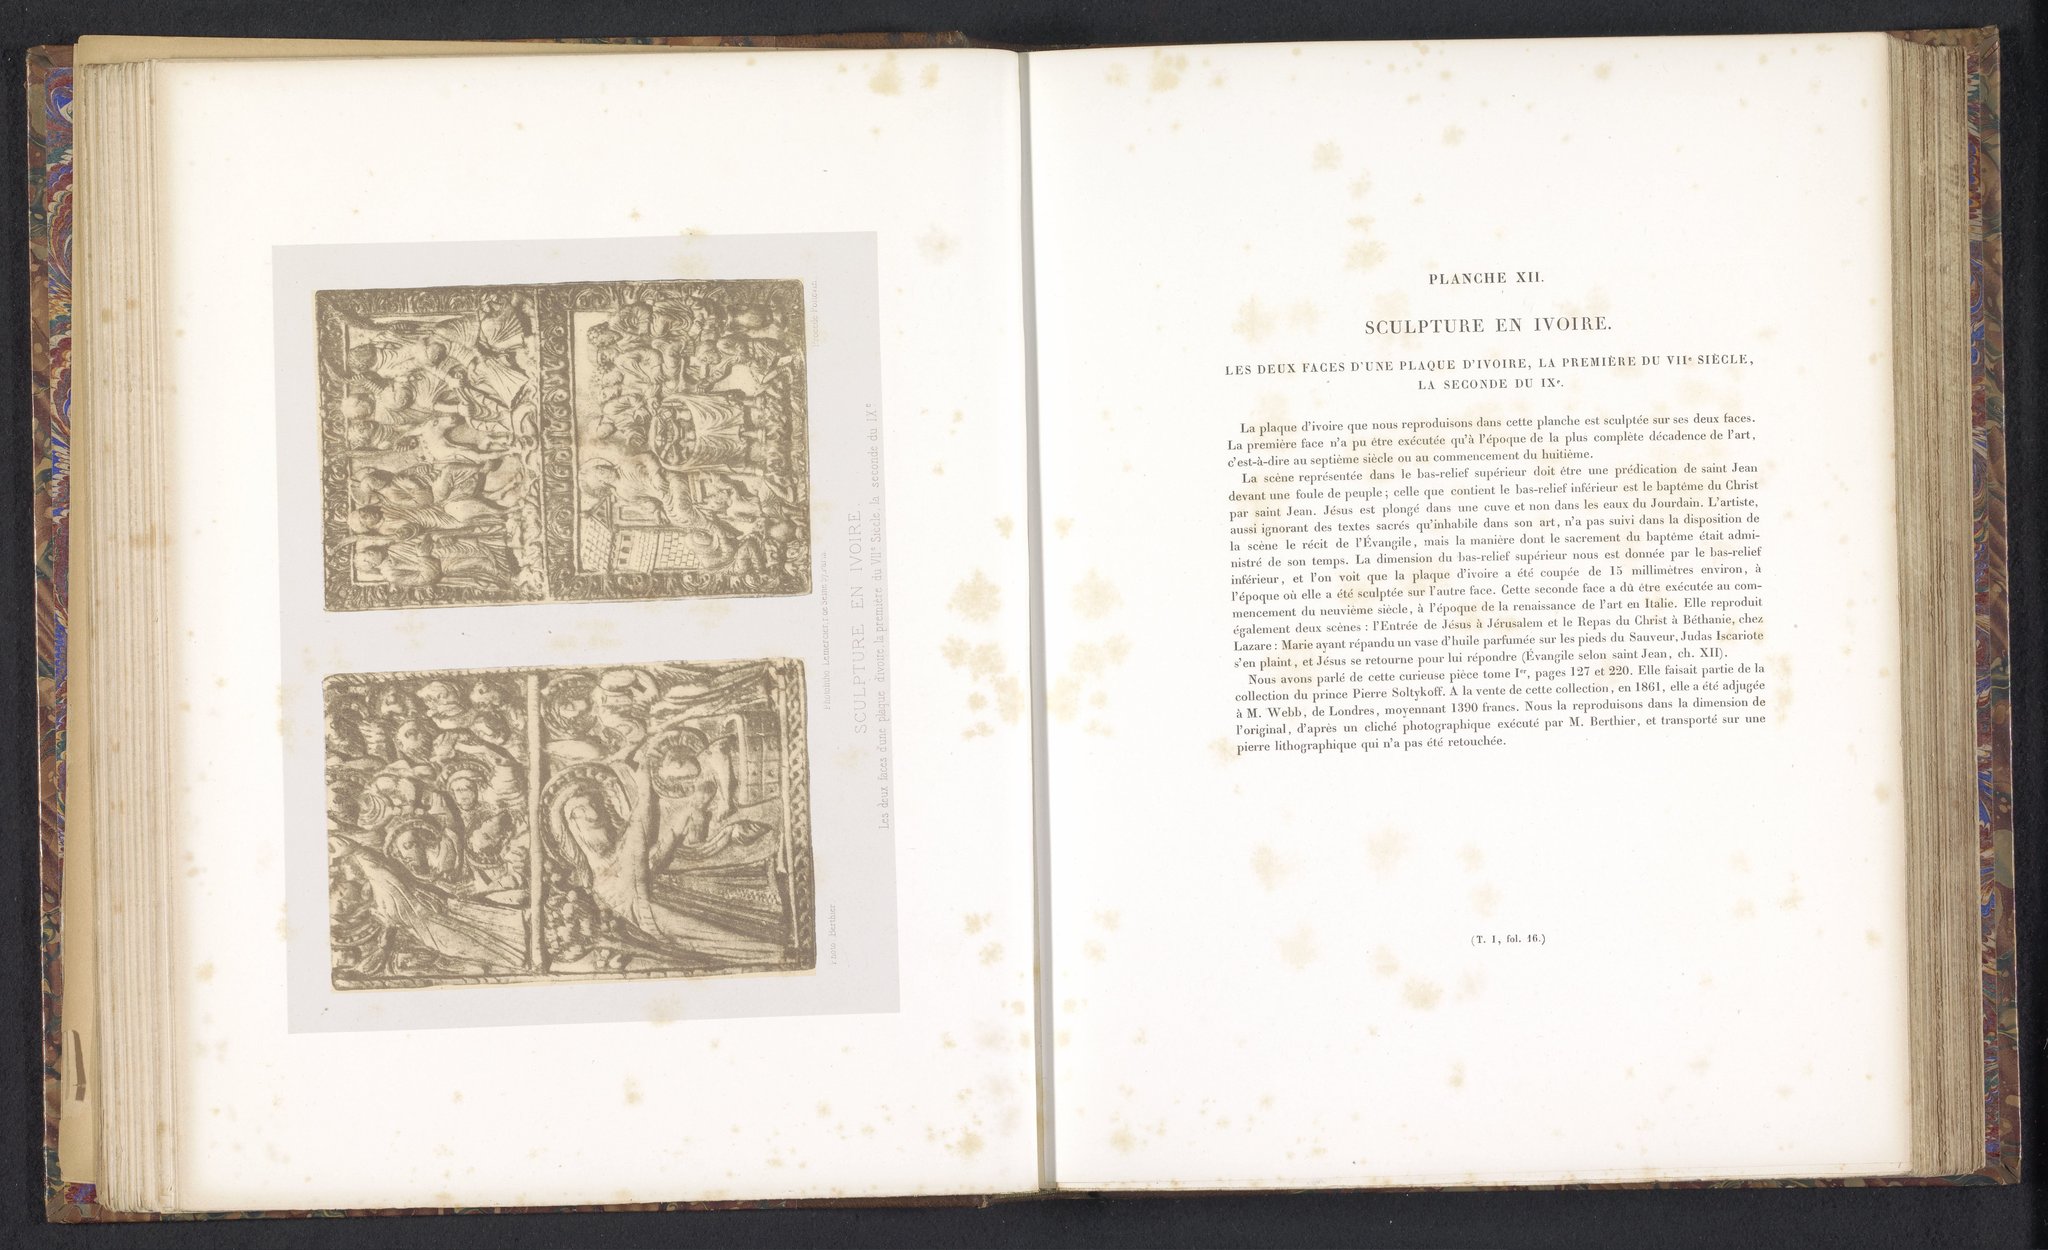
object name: photomechanical print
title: Twee zijden van een ivoren blad met reliëfs, voorstellende de doop van Christus en de intocht van Christus in Jeruzalem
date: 1859-1864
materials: paper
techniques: photolithography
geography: paris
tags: baptism of christ in the river jordan: john the baptist pouring out water on christ's head: the holy ghost descends, entry into jerusalem: people spreading their clothes before christ on the ass, and waving palm branches (matthew 21:1-11, 21:14-16; mark 11:1-11; luke 19:28-40; john 12:12-19), sculpture (+ relief ~ sculpture)